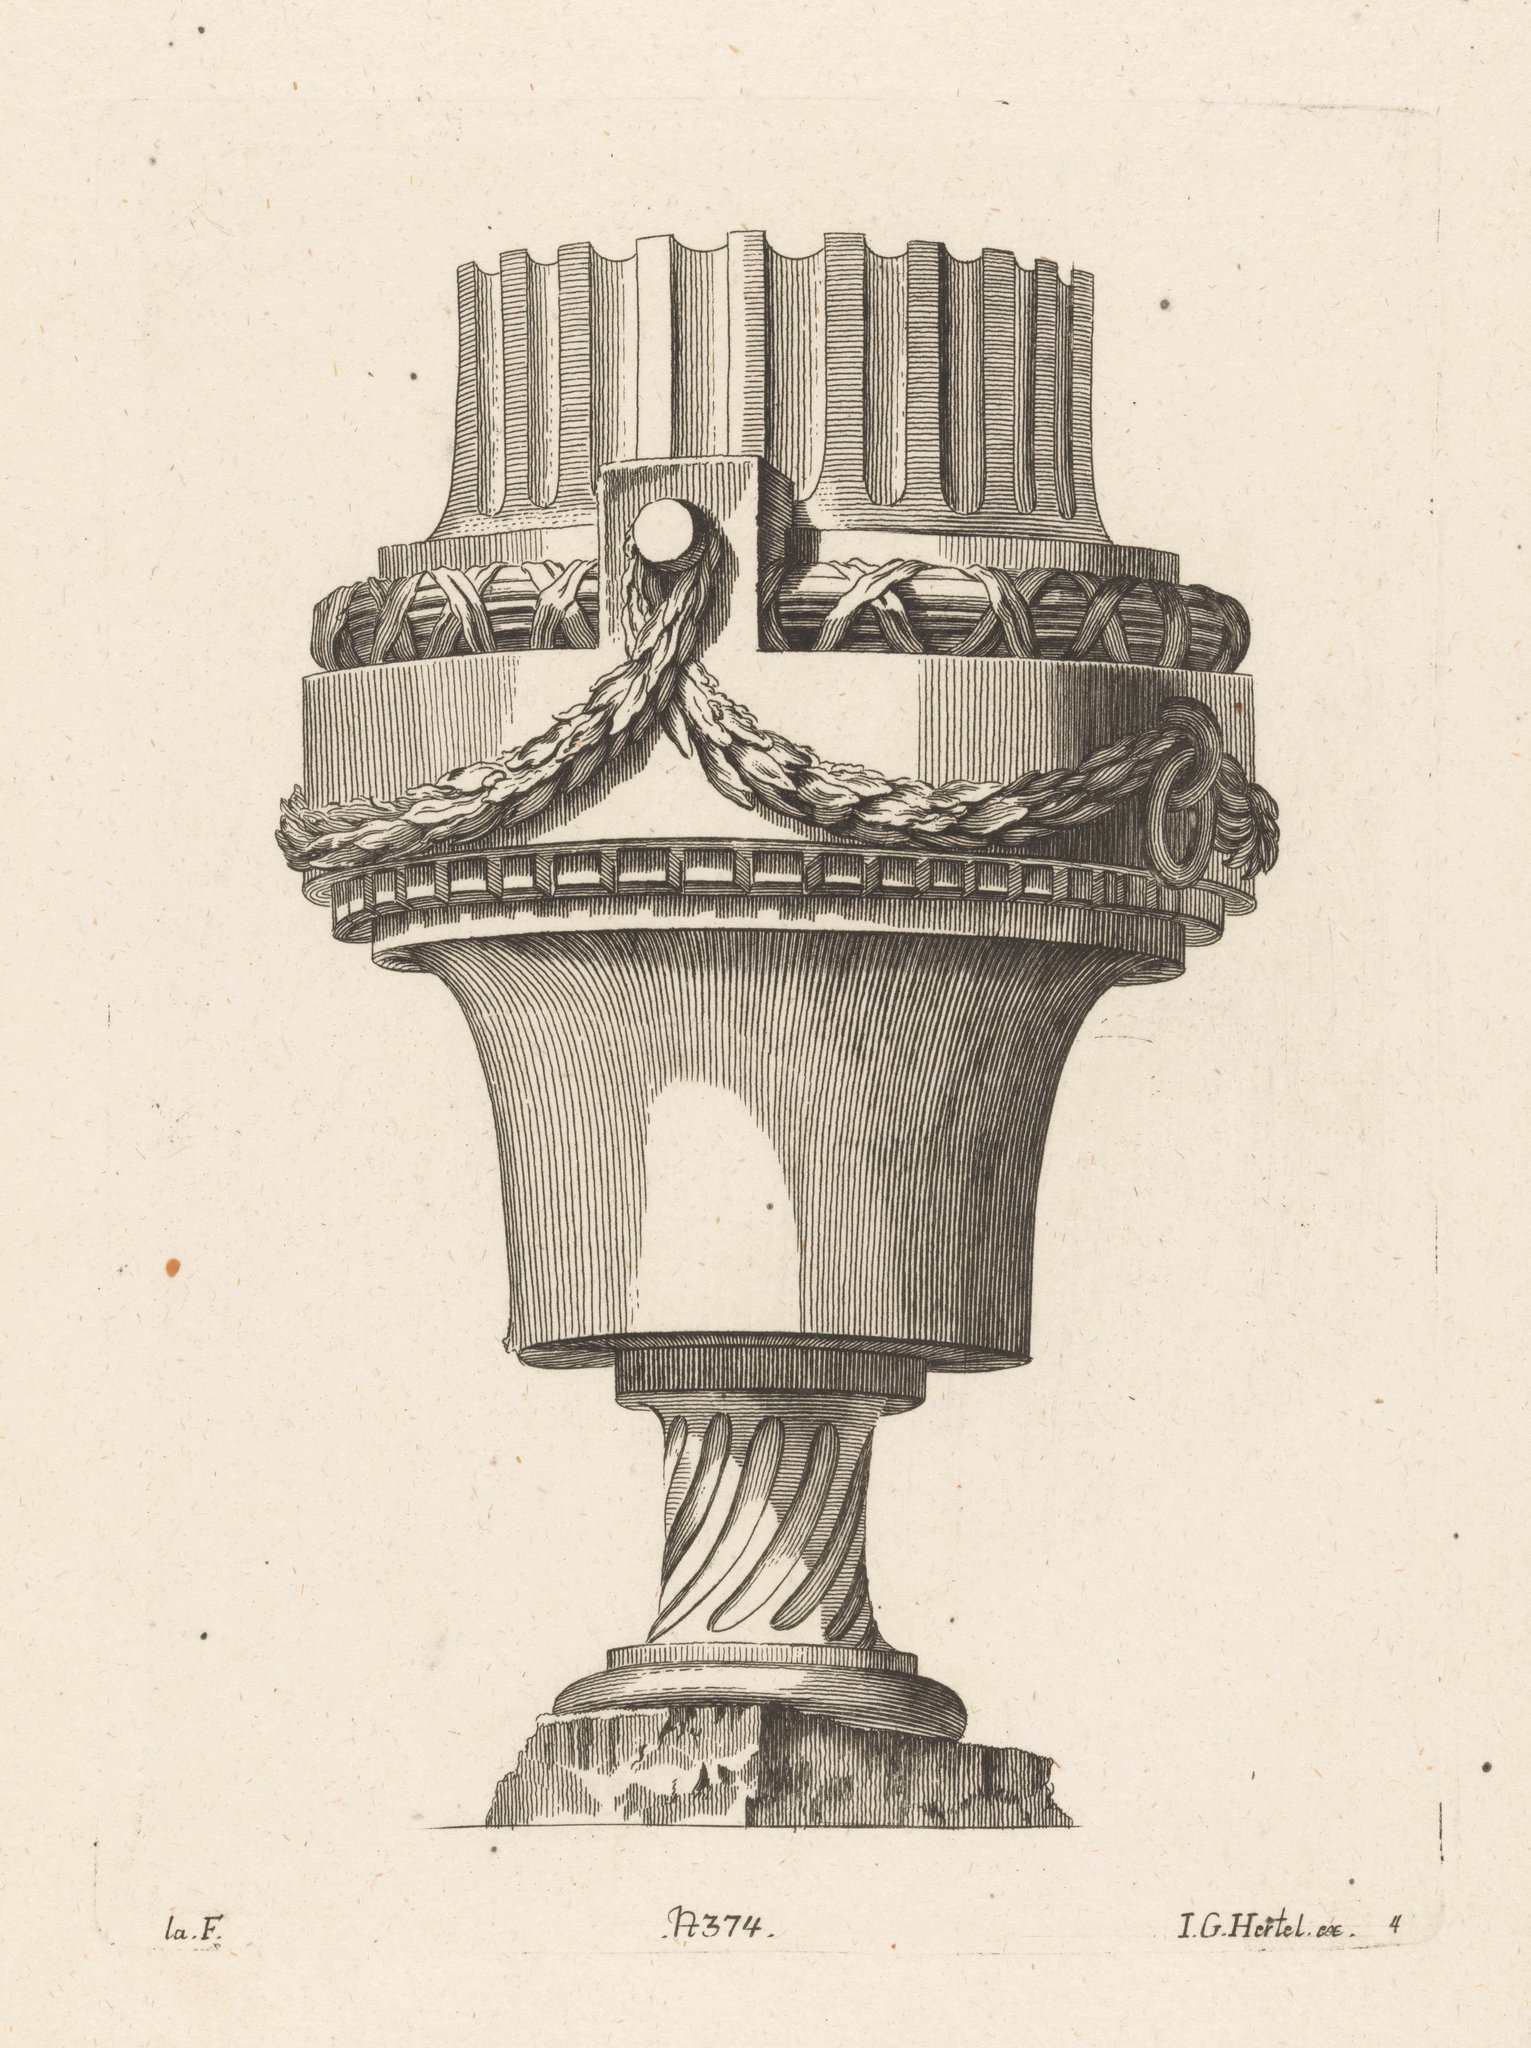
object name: print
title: Vaas met guirlandes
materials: paper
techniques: engraving, etching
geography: germany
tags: vase ~ ornament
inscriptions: collector's mark: Lugt 2228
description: Kopie naar V Vases antiques. Cahier V, IIe Volume De l'Oeuvre de J. Ch. Delafosse (...), prent drie van zes.